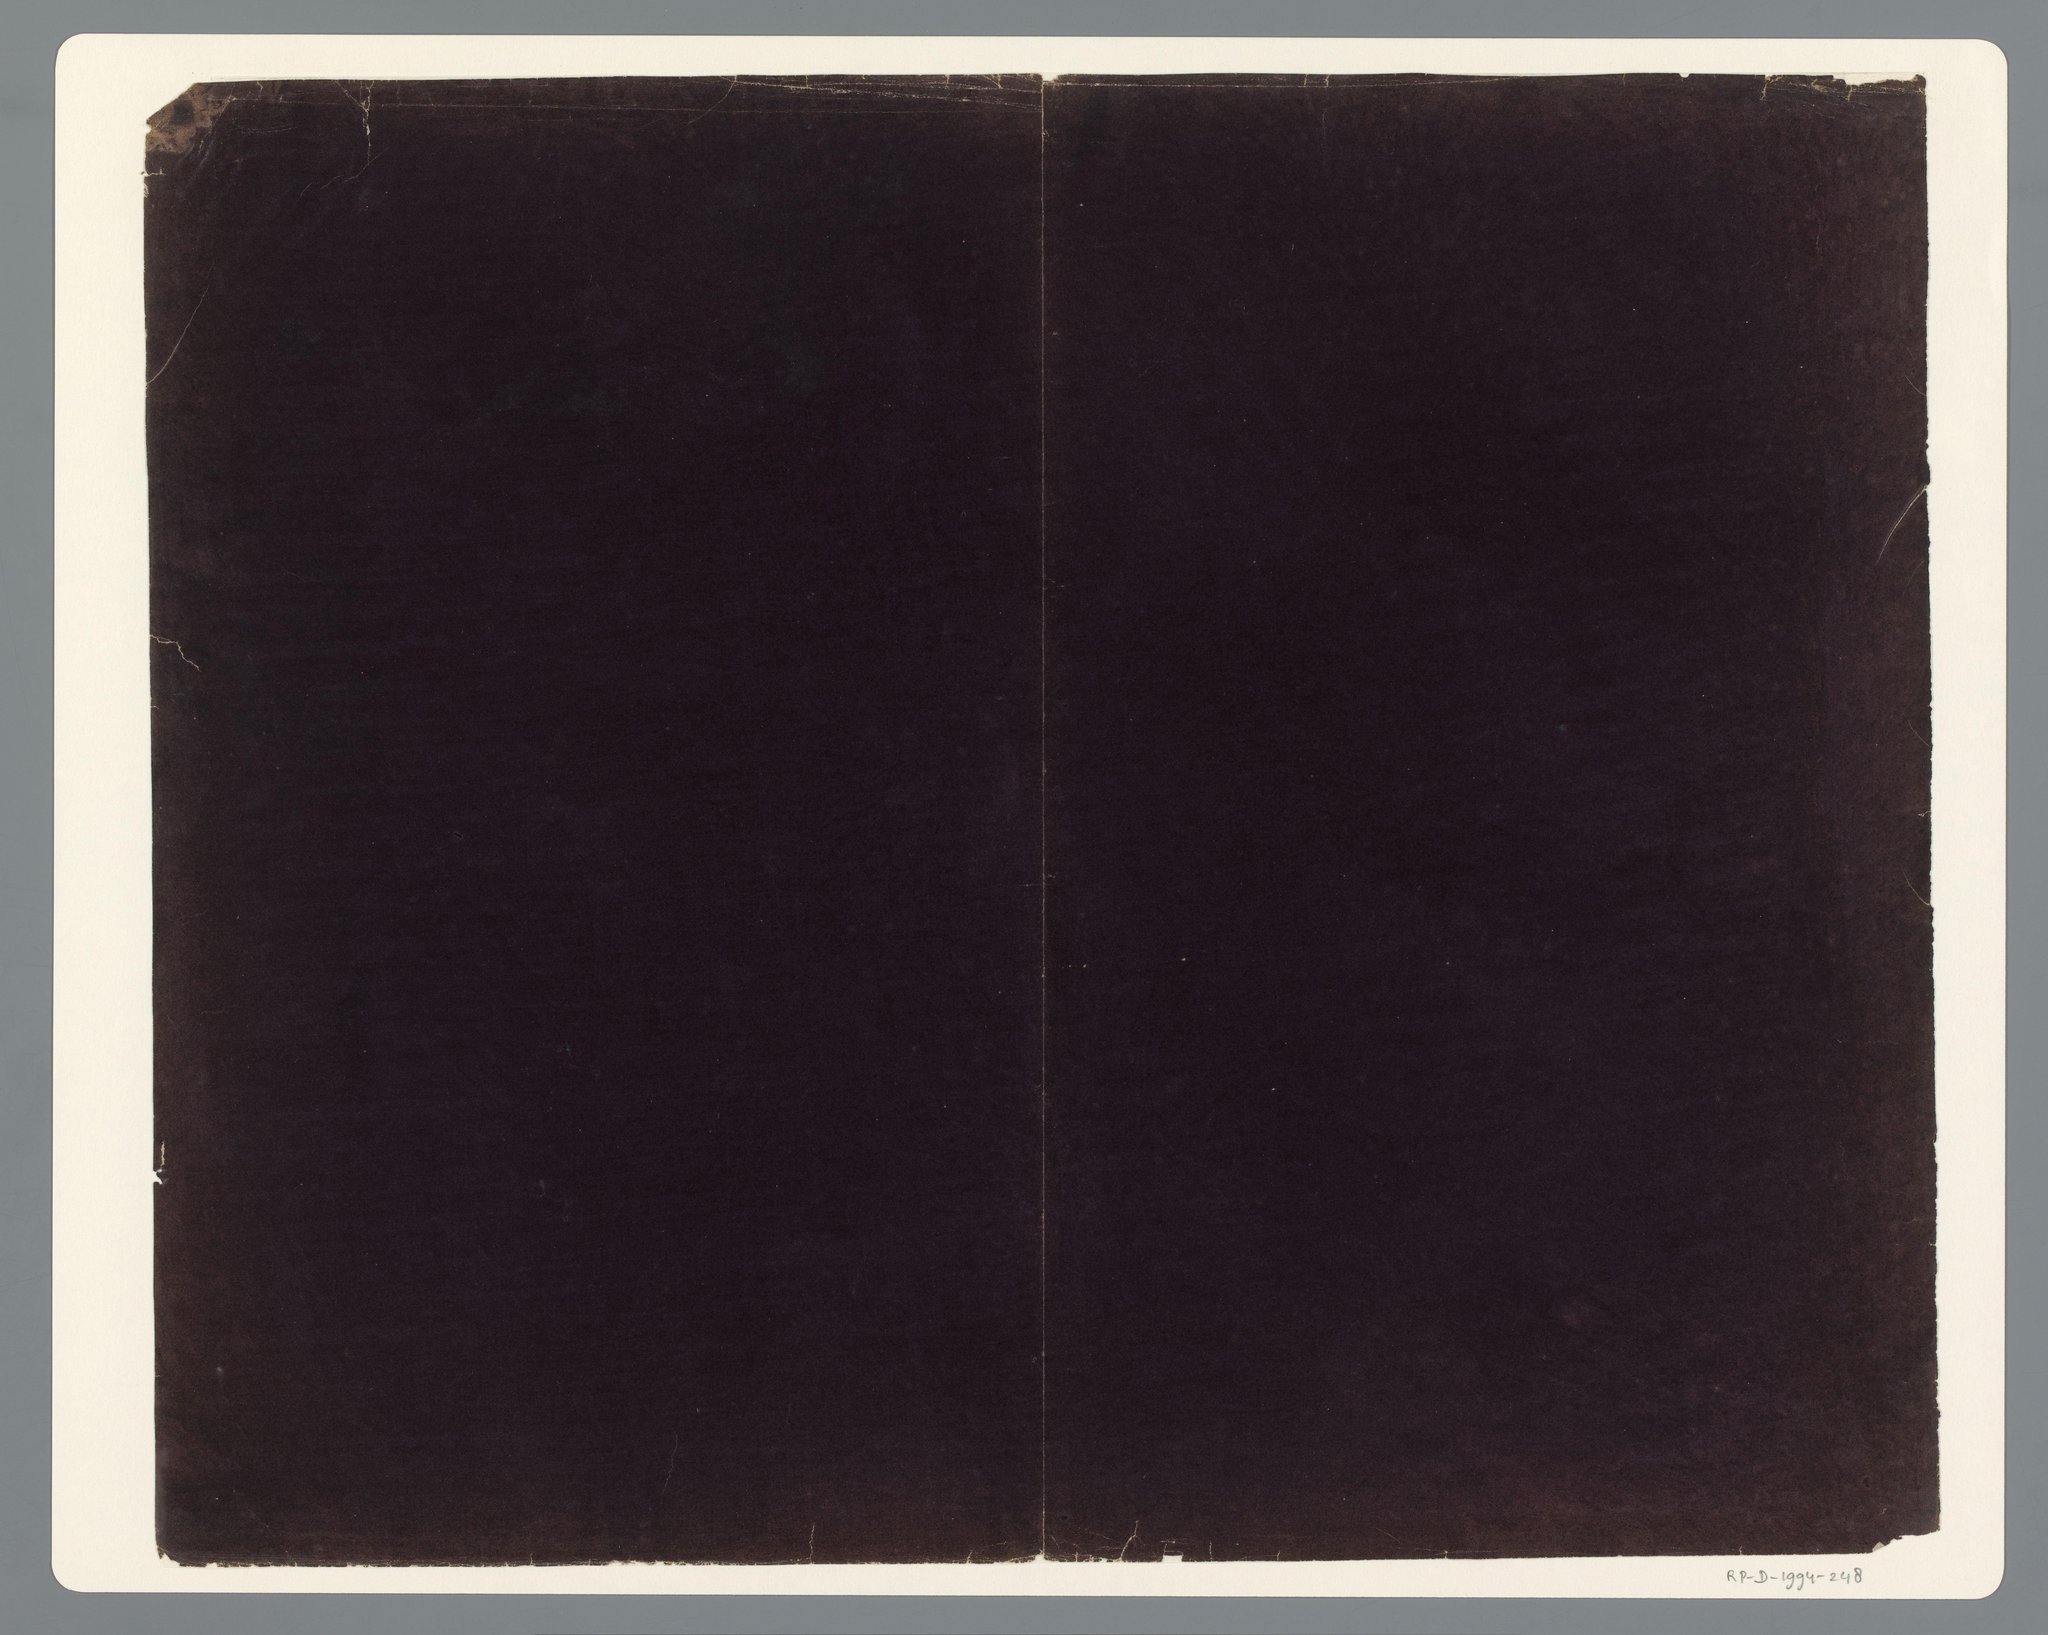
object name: decorated paper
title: Effen donkerpaars papier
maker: Anonymous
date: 1860-1920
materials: lacquer, paint, paper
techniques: hand coloring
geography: aschaffenburg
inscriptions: collector's mark: Lugt 2228